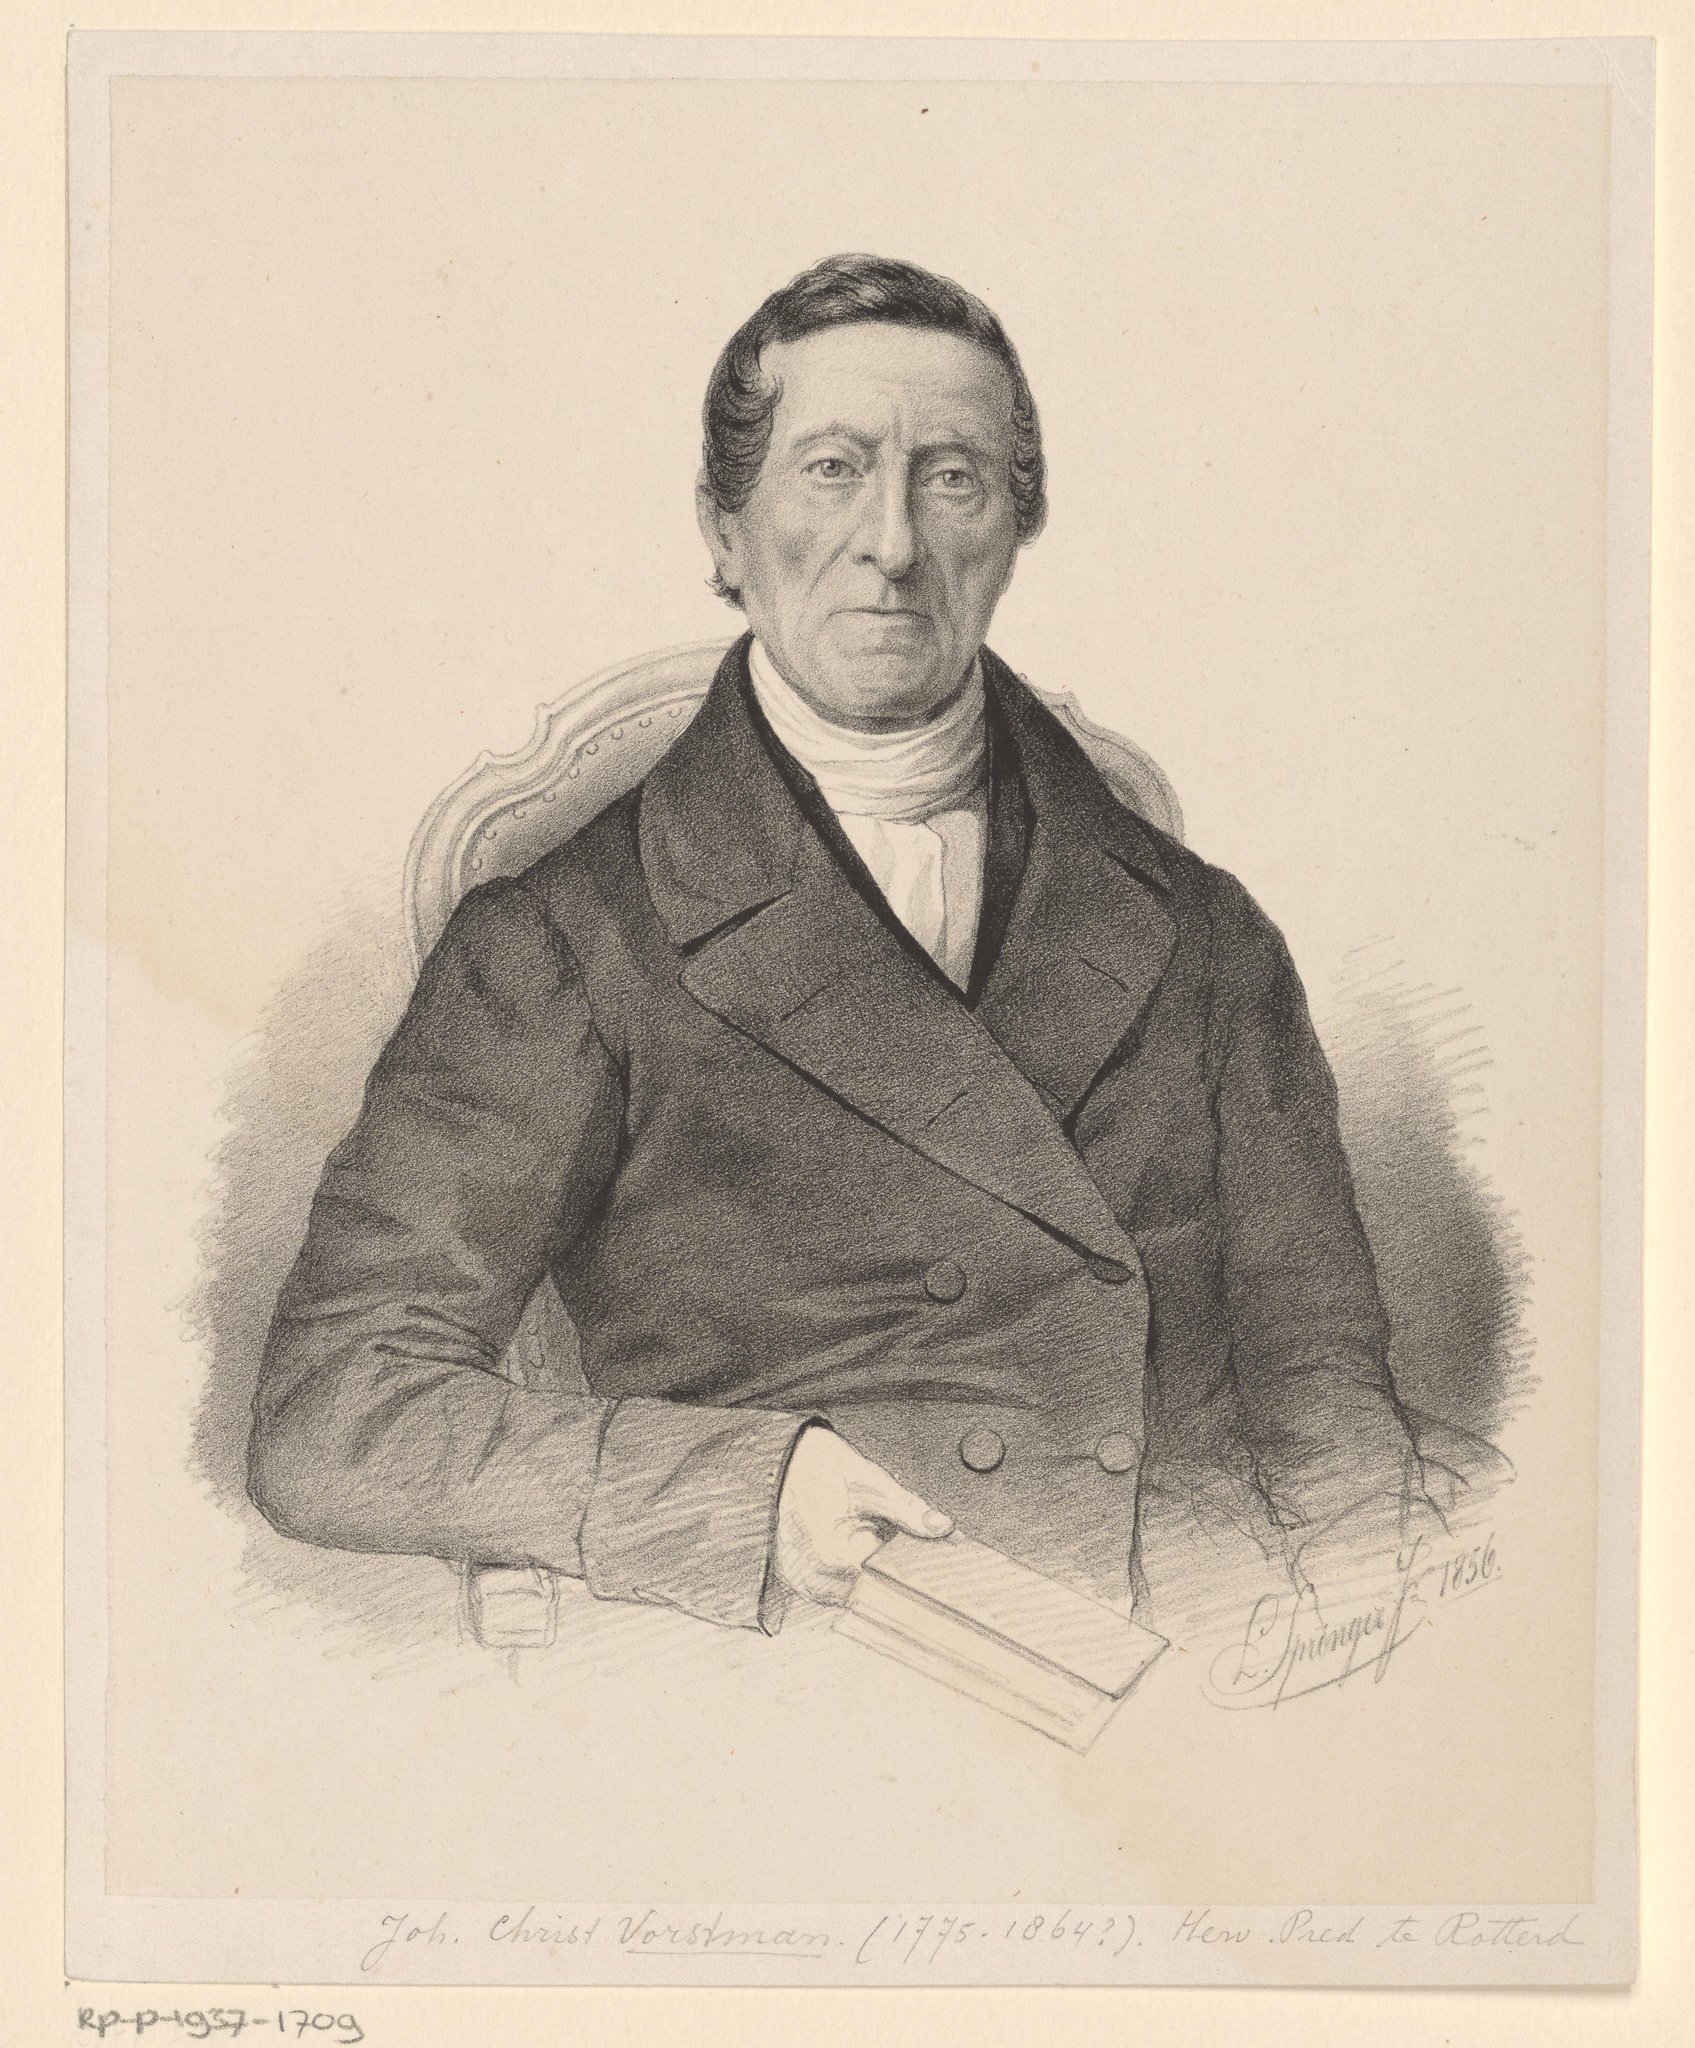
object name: print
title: Portret van Johannes Christianus Vorstman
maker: leendert springer (ii)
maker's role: draughtsman, print maker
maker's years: 1831-1894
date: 1856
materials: paper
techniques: lithograph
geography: netherlands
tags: theologian, historical persons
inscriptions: collector's mark: Lugt 2760, collector's mark: Lugt 2228